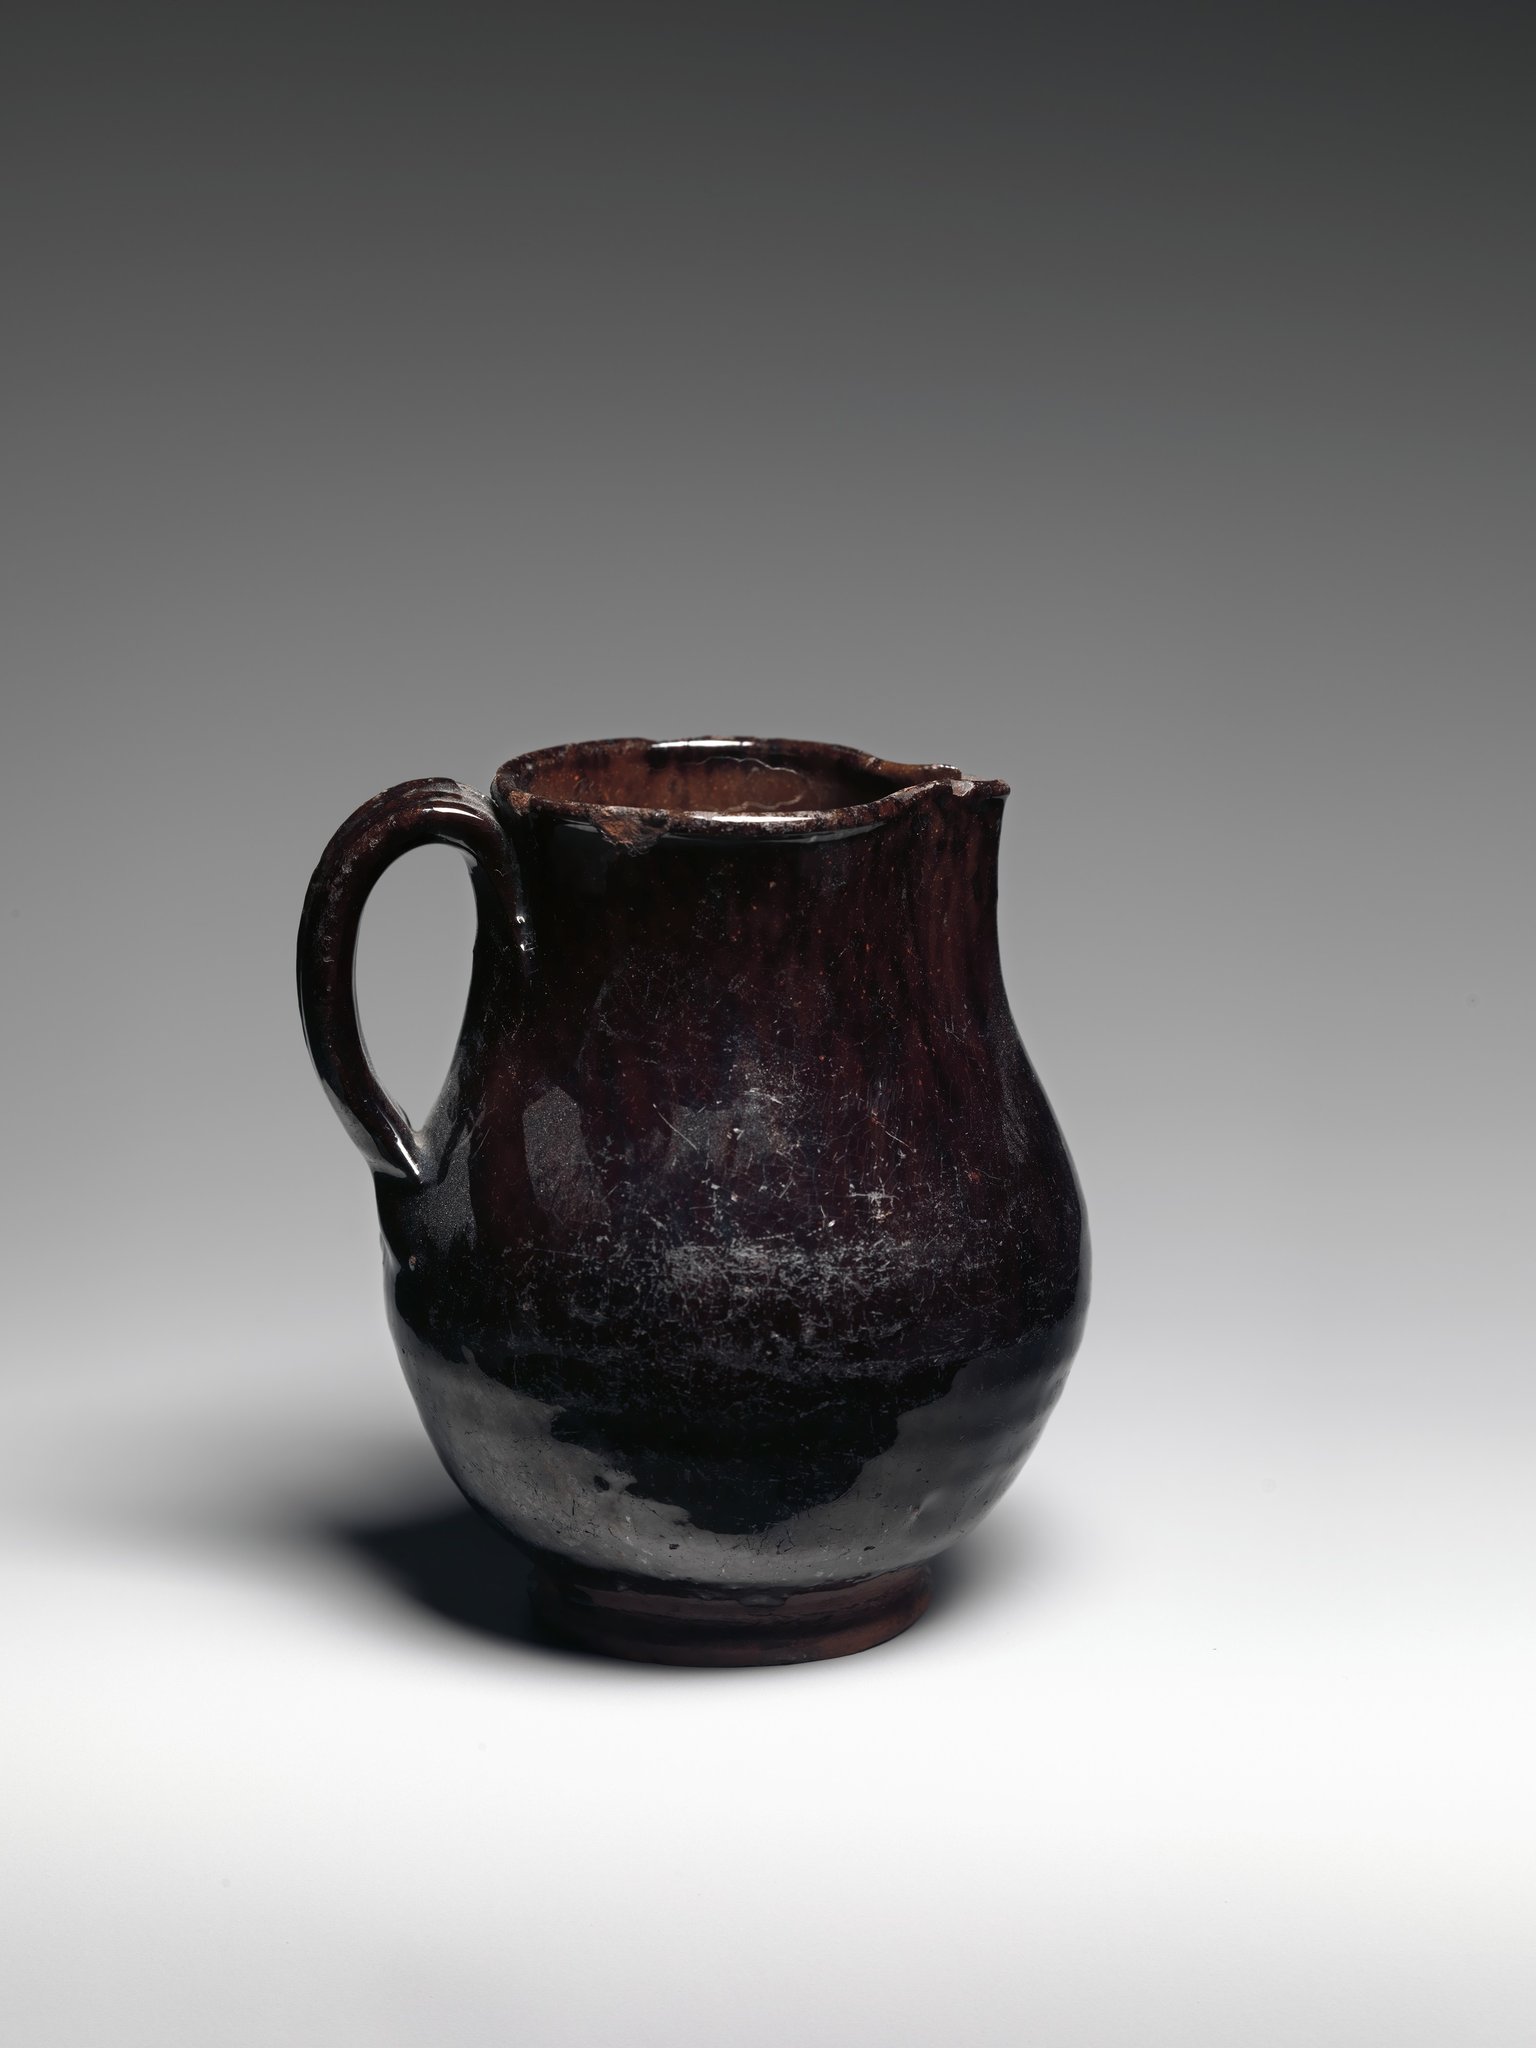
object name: pitcher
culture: american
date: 1800-1830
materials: earthenware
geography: new england